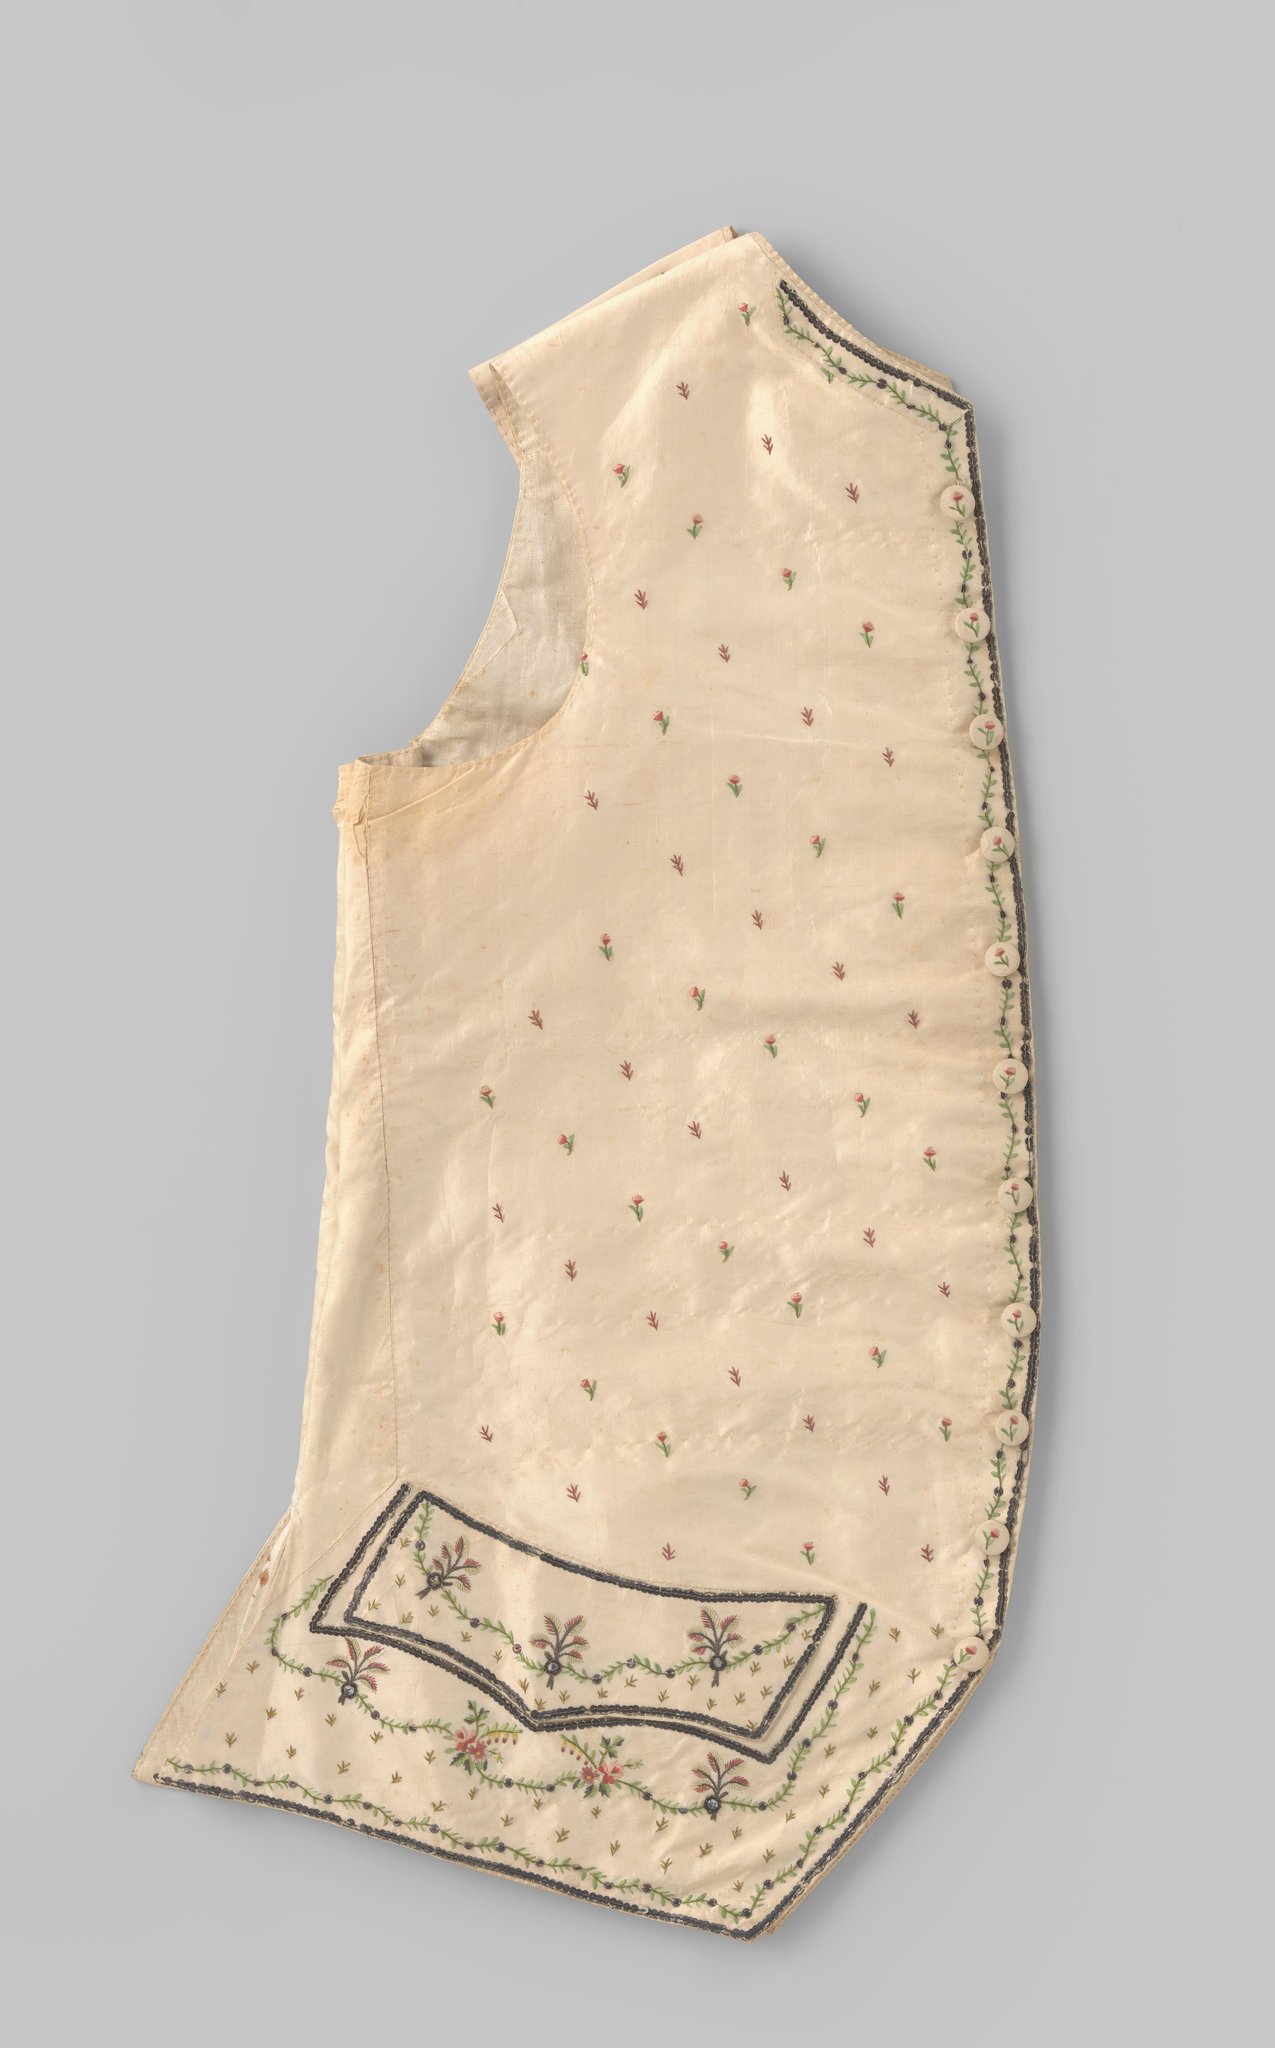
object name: clothing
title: Vest met elf stofknopen en twee zakken met klep, van crème zijde, geborduurd met een floraal strooimotief en bladranken met tuilen bloemen, pailletten en gekleurde stenen.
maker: Anonymous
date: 1780-1790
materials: linen, paste, silk, silver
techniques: embroidered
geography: netherlands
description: Herenvest (vest) van roomkleurige zijde, geborduurd met floraal motief in veelkleurige zijde, zilver canetille, zilveren en rode pailletten en strass. Model: ronde hals, voorpanden van onderen schuin weggesneden. Steekzakken met zakkleppen. Achterpand en voering van linnen. Tussenzetsels van beige, gekeperde zijde aan weerskanten bij zijnaad. Sluiting middenvoor door middel van 11 knoopjes en knoopsgaten. Versiering: strooimotief van roze/rode bloemen op groene stelen afgewisseld met wijnrode takken. Op de zakkleppen een guirlande met drie boeketten van rode en gele zijde waarop een strass steentje in zilver canetelle. Onder de zakkleppen een guirlande met twee boeketten van rode en gele zijde waartussen twee boeketten met verschillende, veelkleurige bloemen. Aan de voorkant van de hals, langs de voorpanden, de zakkleppen en de zoom afgezet met een rand van zilveren pailletten en een guirlande van zijde, pailletten en zilver canetille. Knopen bekleed met roomkleurige zijde waarop één roze/rode bloem is geborduurd.